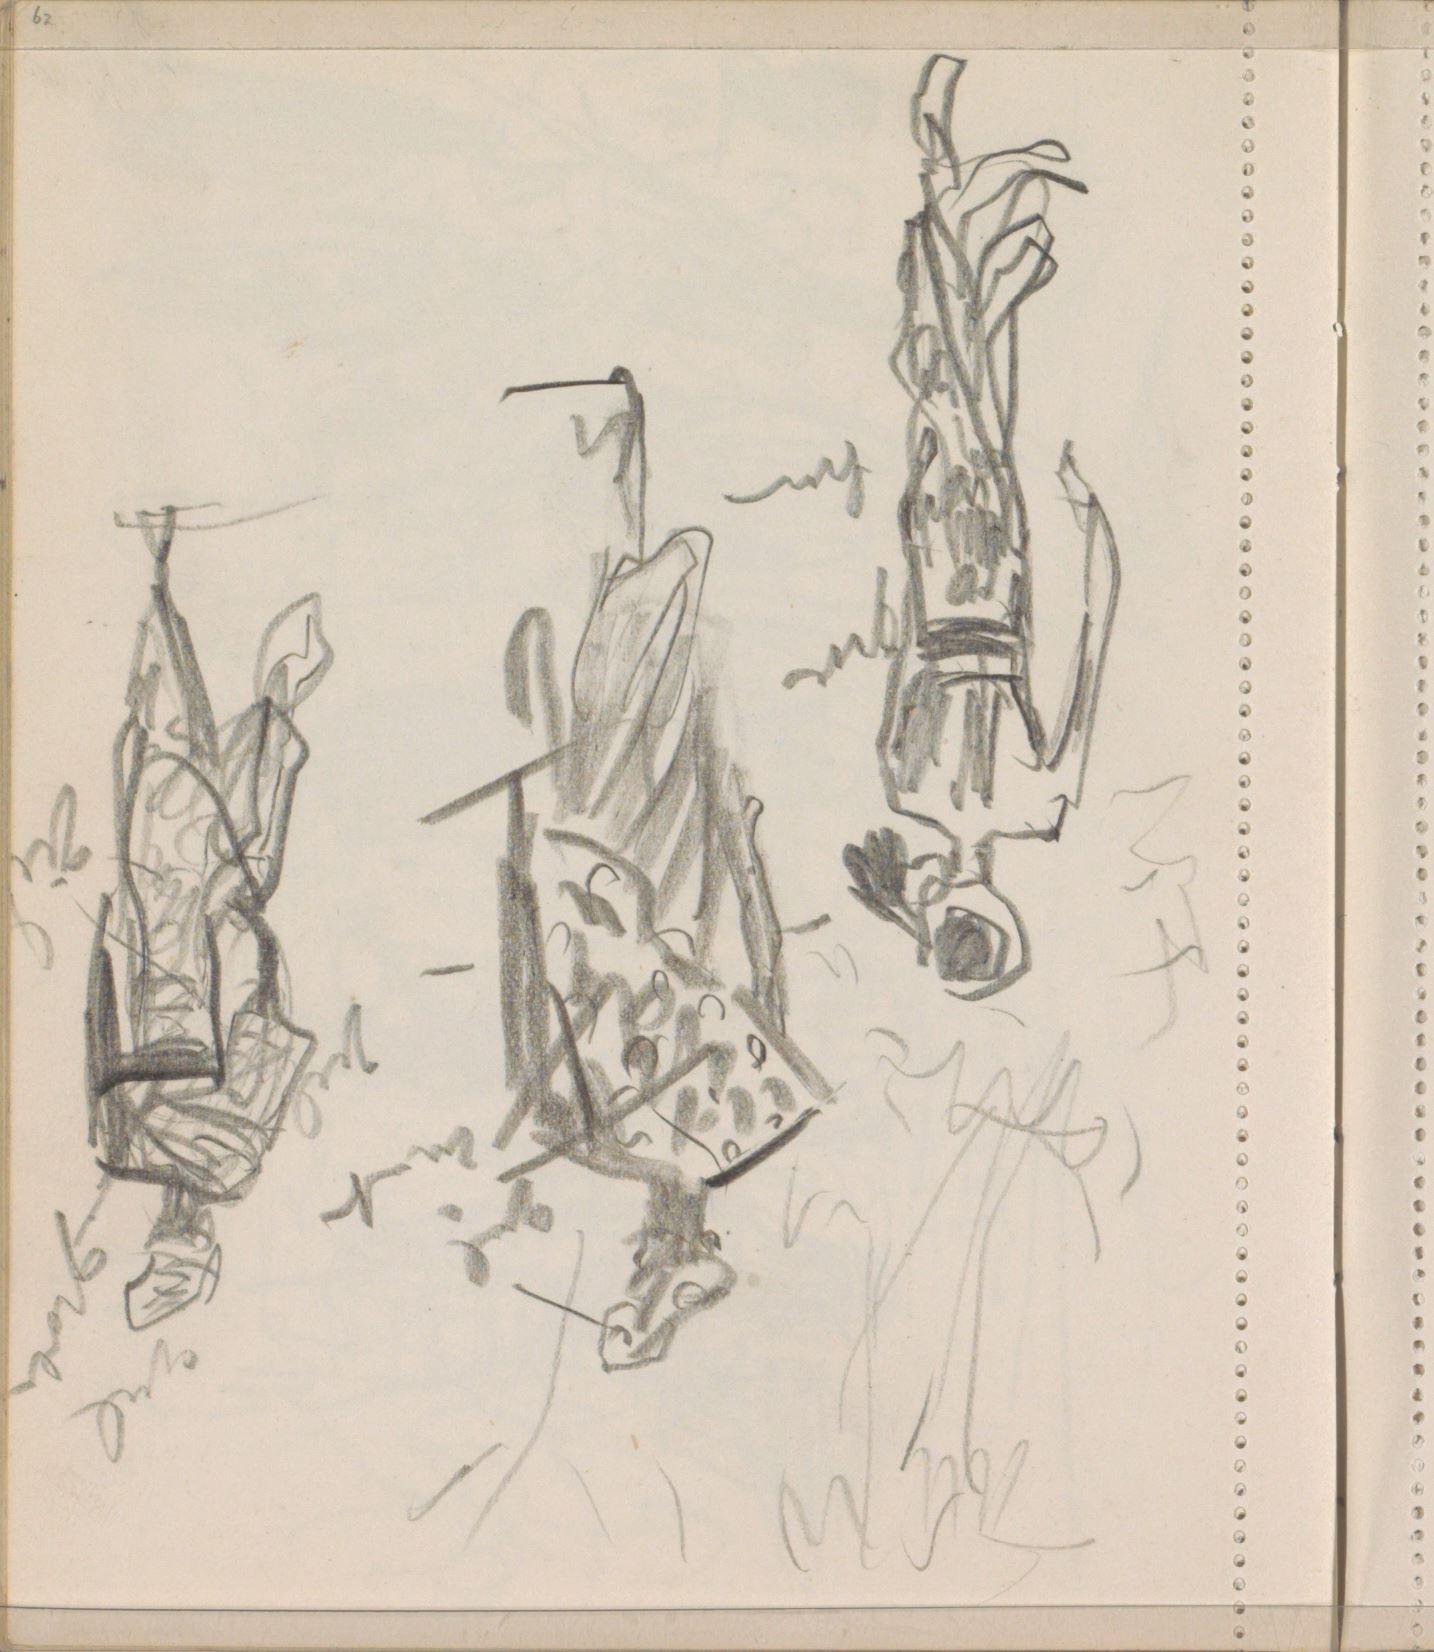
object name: sketchbook leaf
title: Drie Indonesische mannen in traditioneel kostuum, op de rug gezien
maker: marius bauer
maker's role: draughtsman, print maker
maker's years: 1867-1932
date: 1925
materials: chalk, paper, pencil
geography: indonesia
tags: asiatic races and peoples, adult man, folk costume, regional costume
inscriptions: kleurnotitie, handgeschreven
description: Pagina 62 uit een schetsboek met 67 bladen.